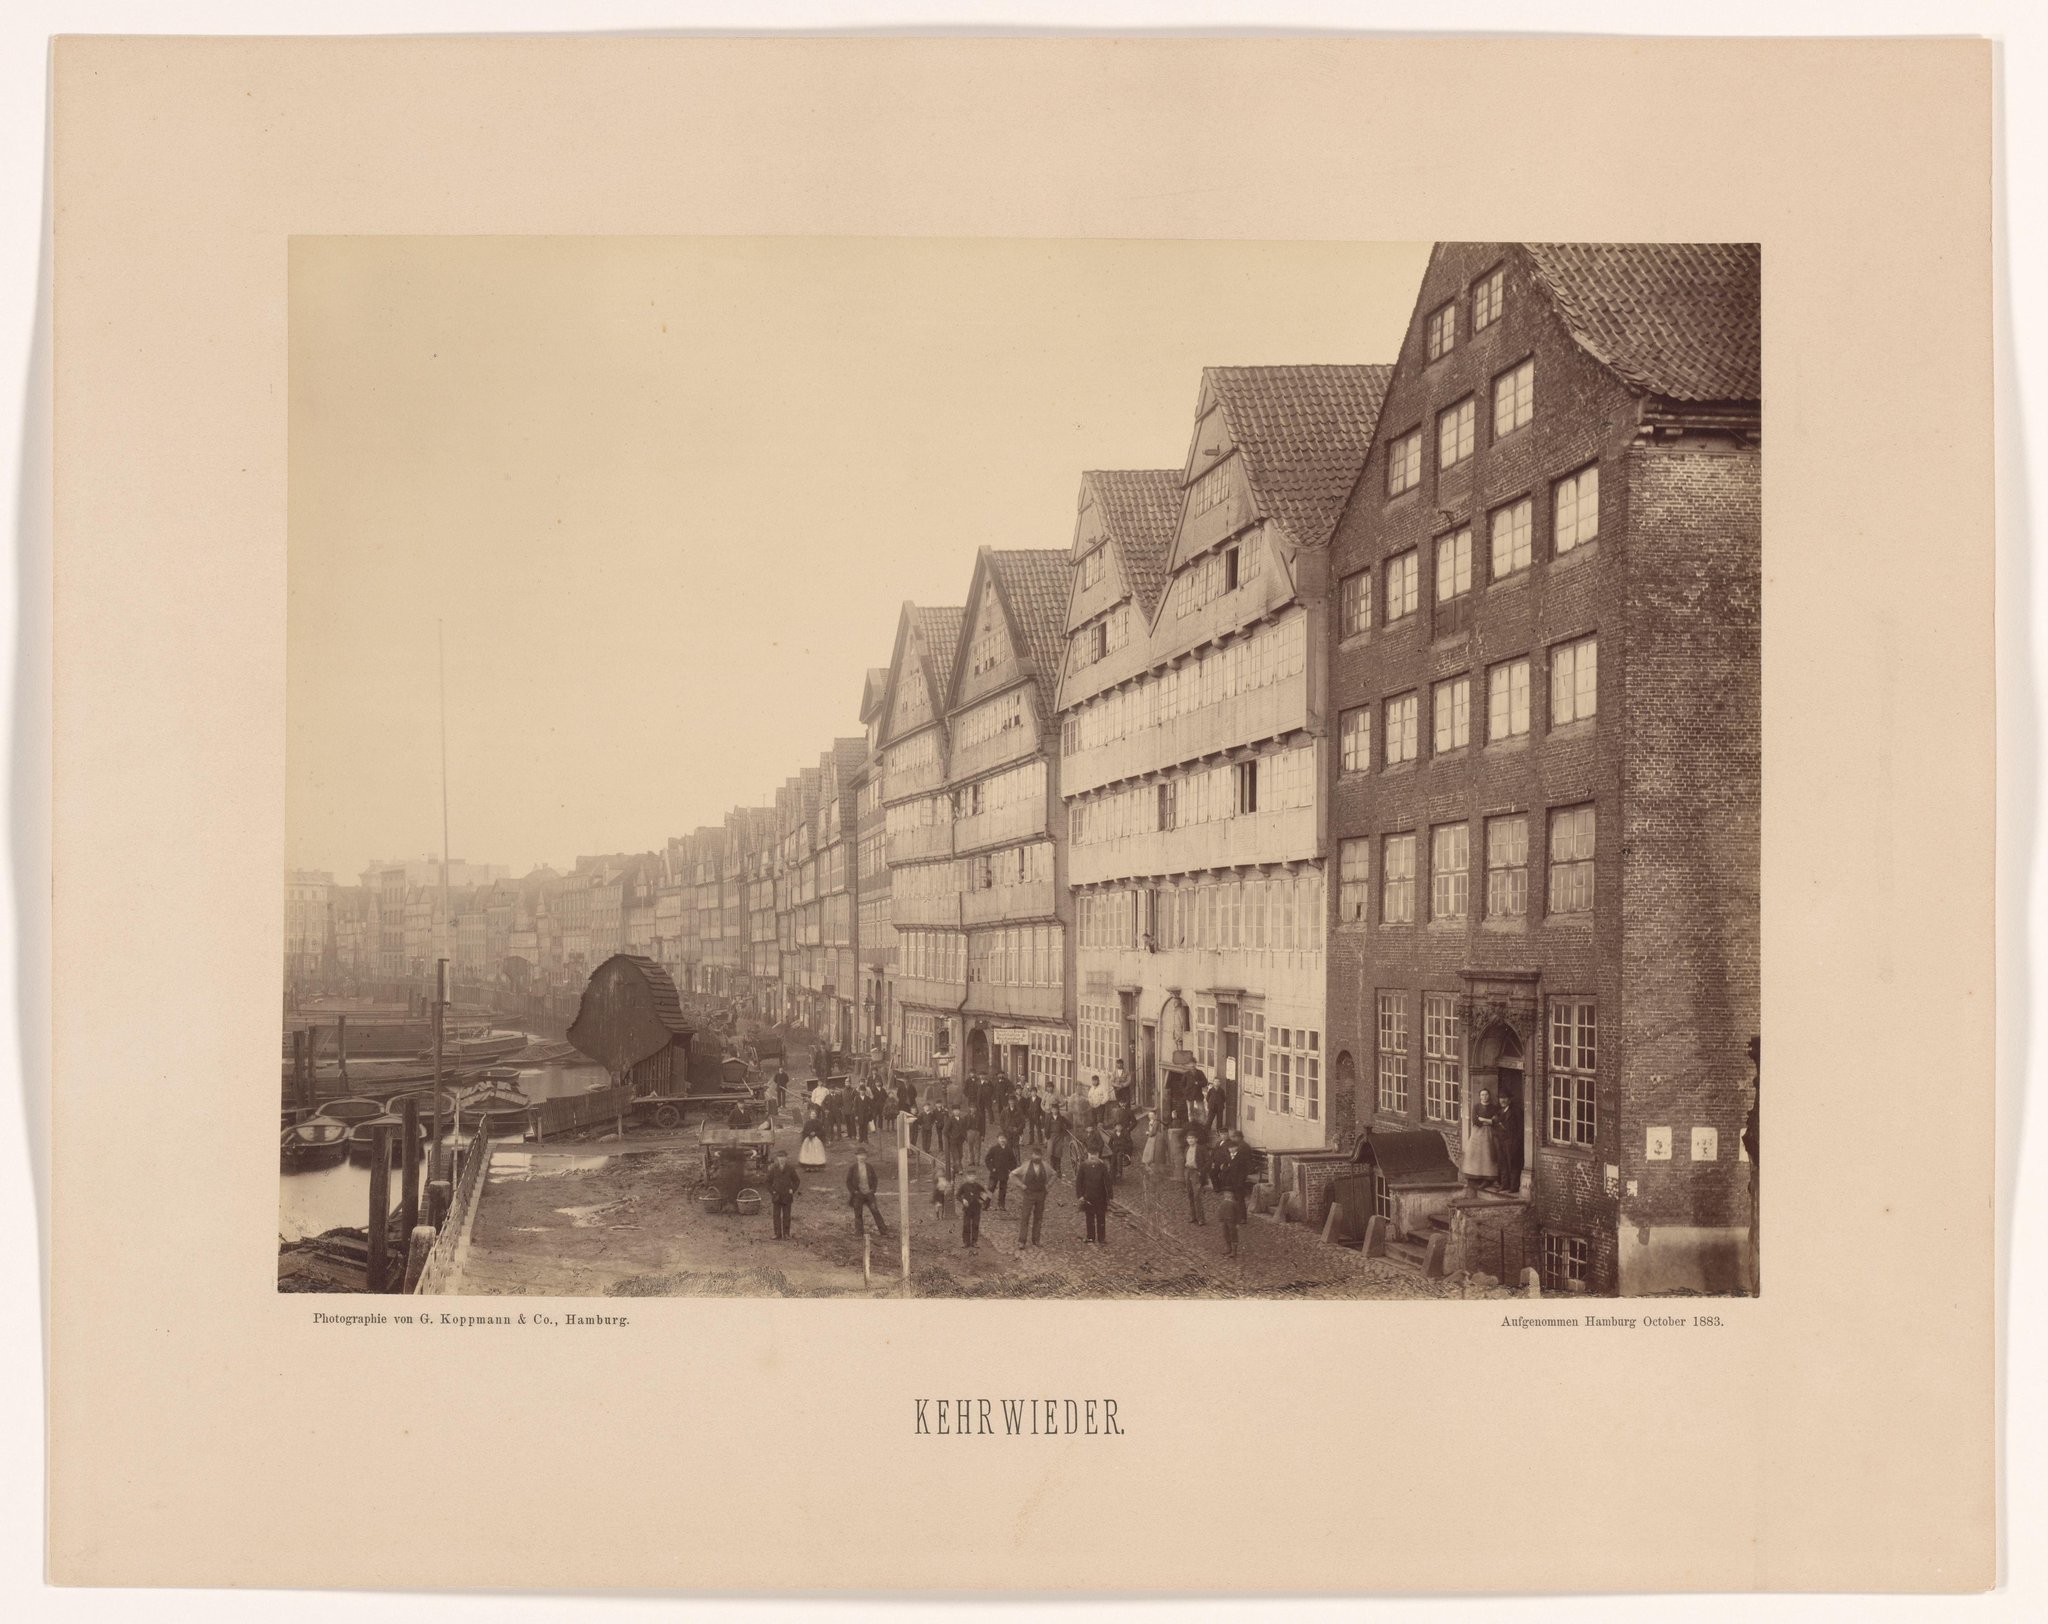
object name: photograph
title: Straatgezicht in de wijk Kehrwieder, Hamburg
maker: georg koppmann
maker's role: fotograaf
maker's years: 1842-1909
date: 1810-1883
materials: cardboard, paper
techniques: albumen print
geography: hamburg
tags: urban housing, street (+ city(-scape) with figures, staffage)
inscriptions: date: ‘Aufgenommen Hamburg October 1883.’, annotation: ‘27157/1b’, signature: ‘Photographie von G. Koppmann & Co., Hamburg.’